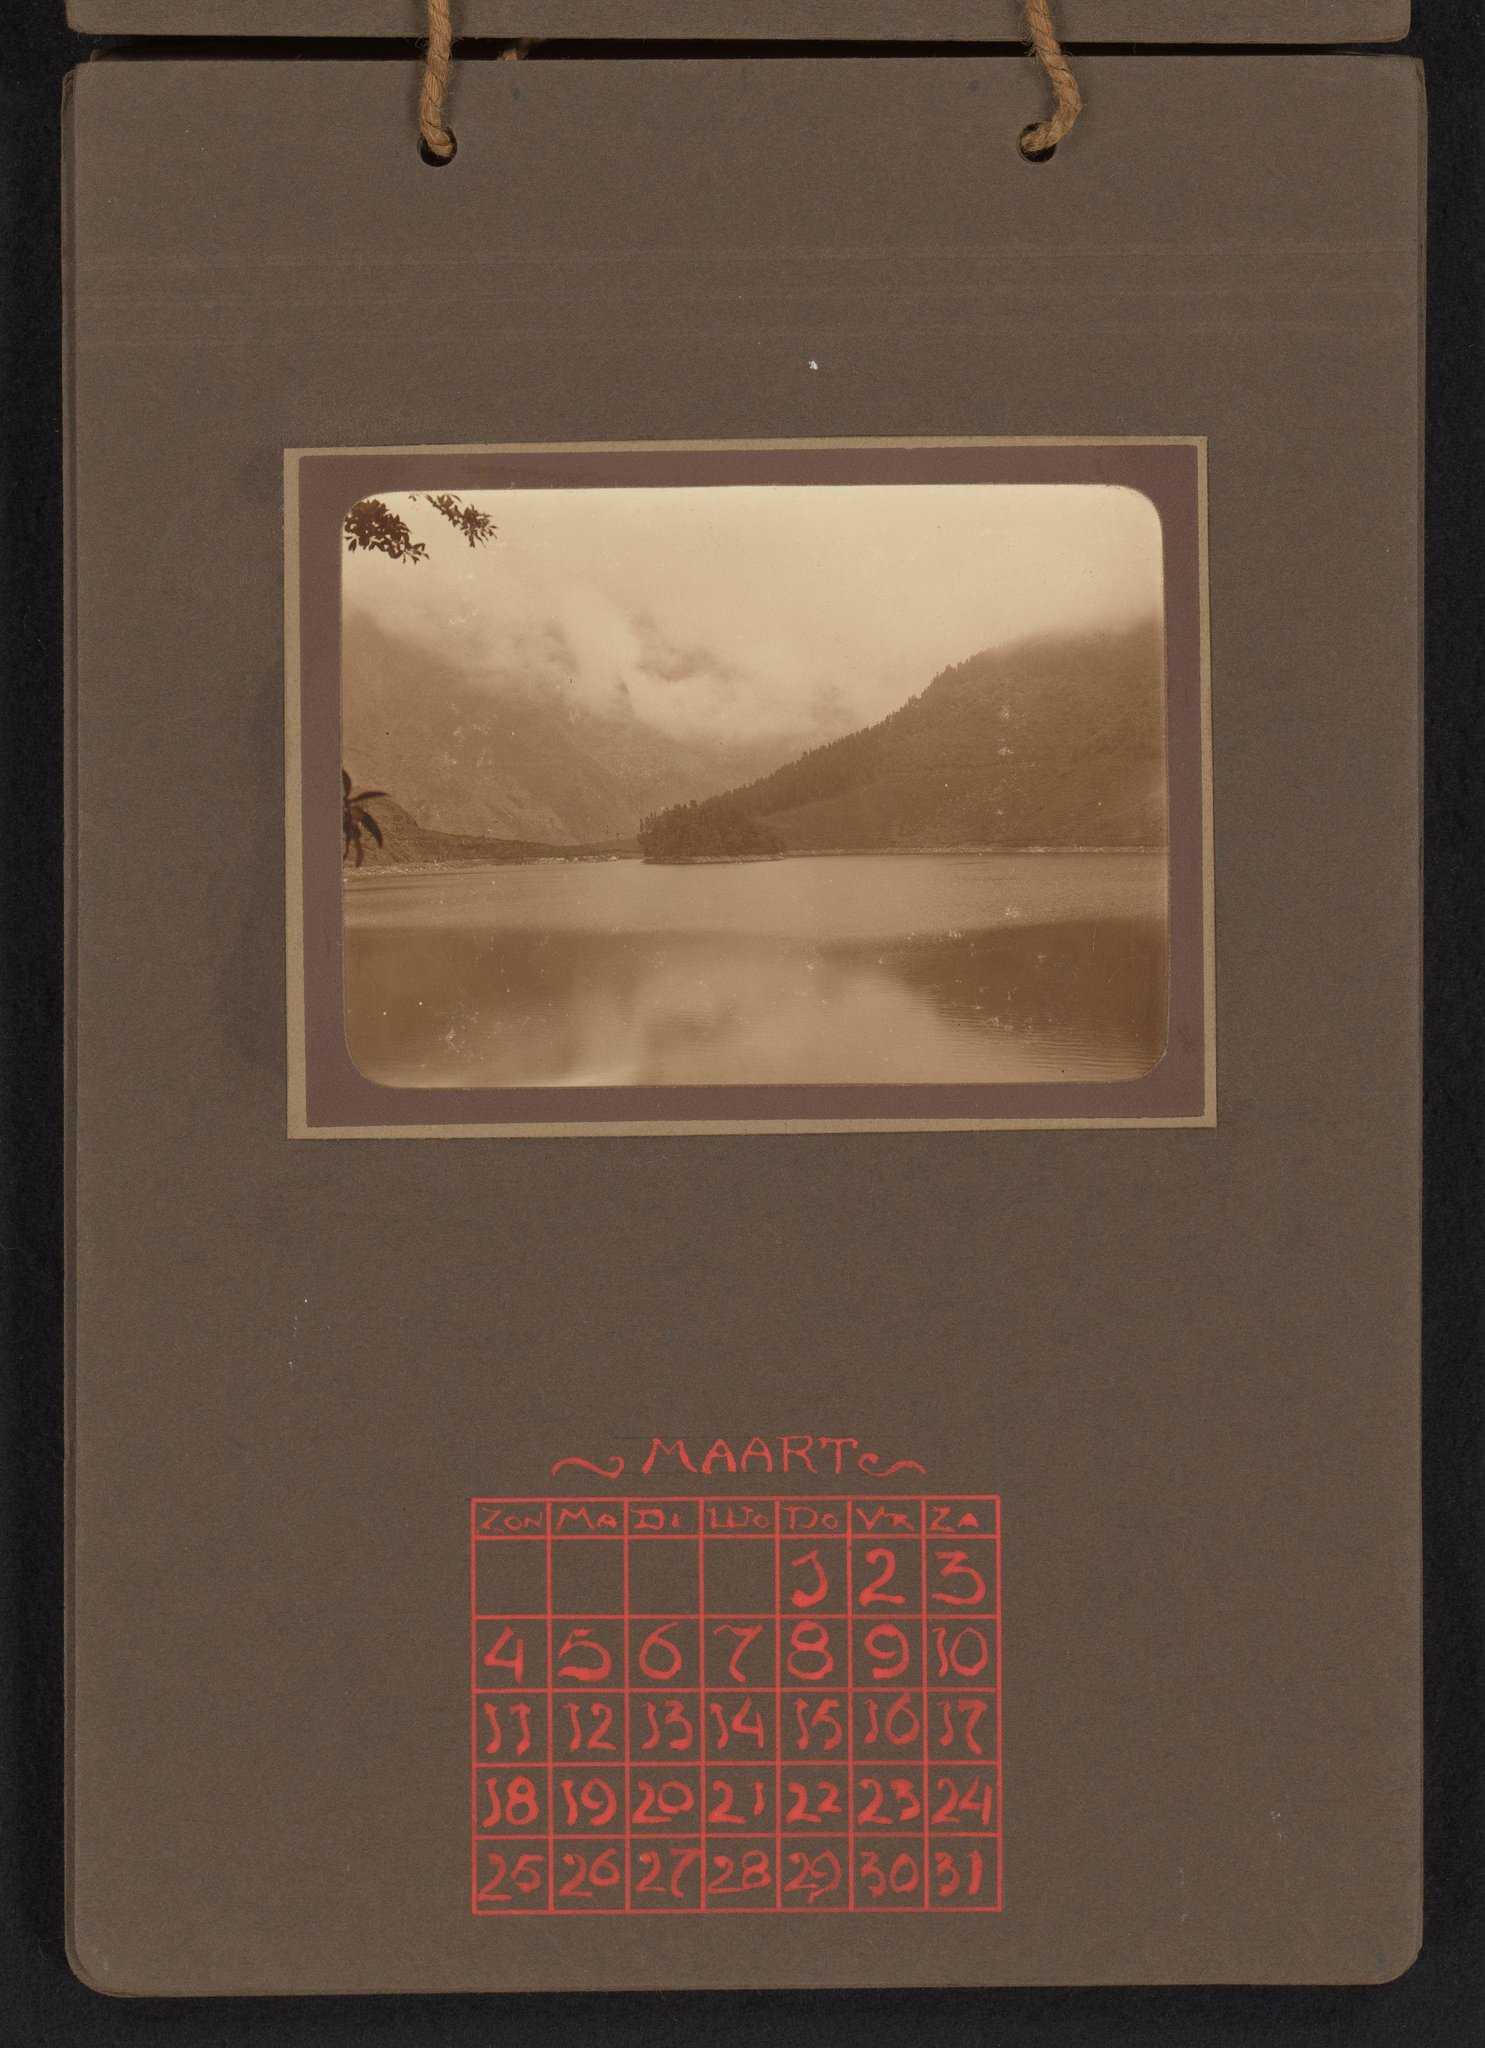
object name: album leaf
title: Landschap met bergen en meer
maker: Anonymous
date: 1880-1923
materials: cardboard, paper, photographic support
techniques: collodion silver print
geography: indonesia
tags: lake, mountains, indonesia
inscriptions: annotation: ‘MAART/ (...)’